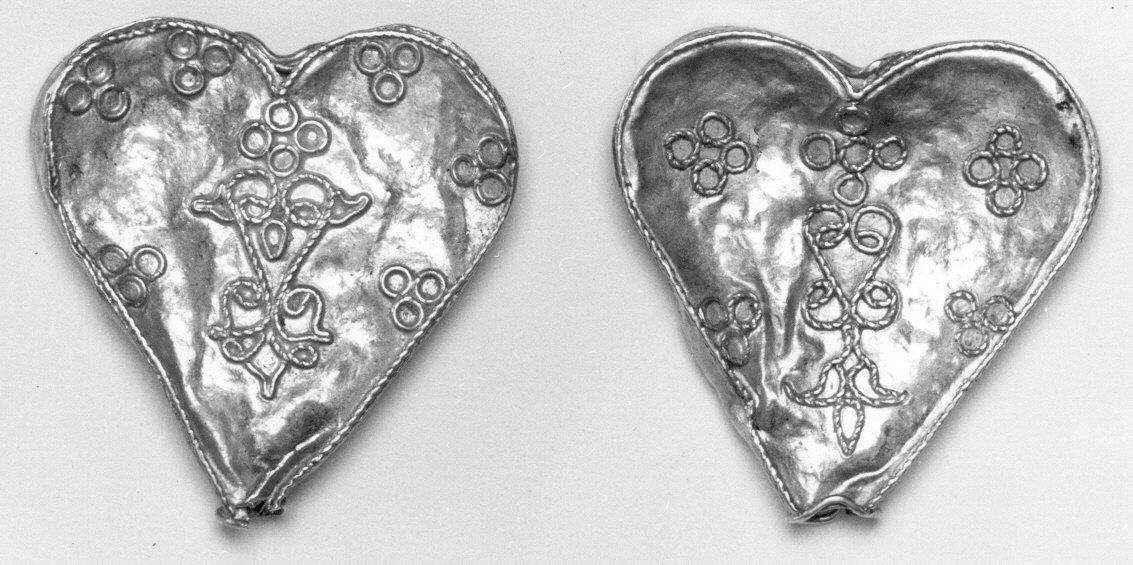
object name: element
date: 1001-1200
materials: gold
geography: iran